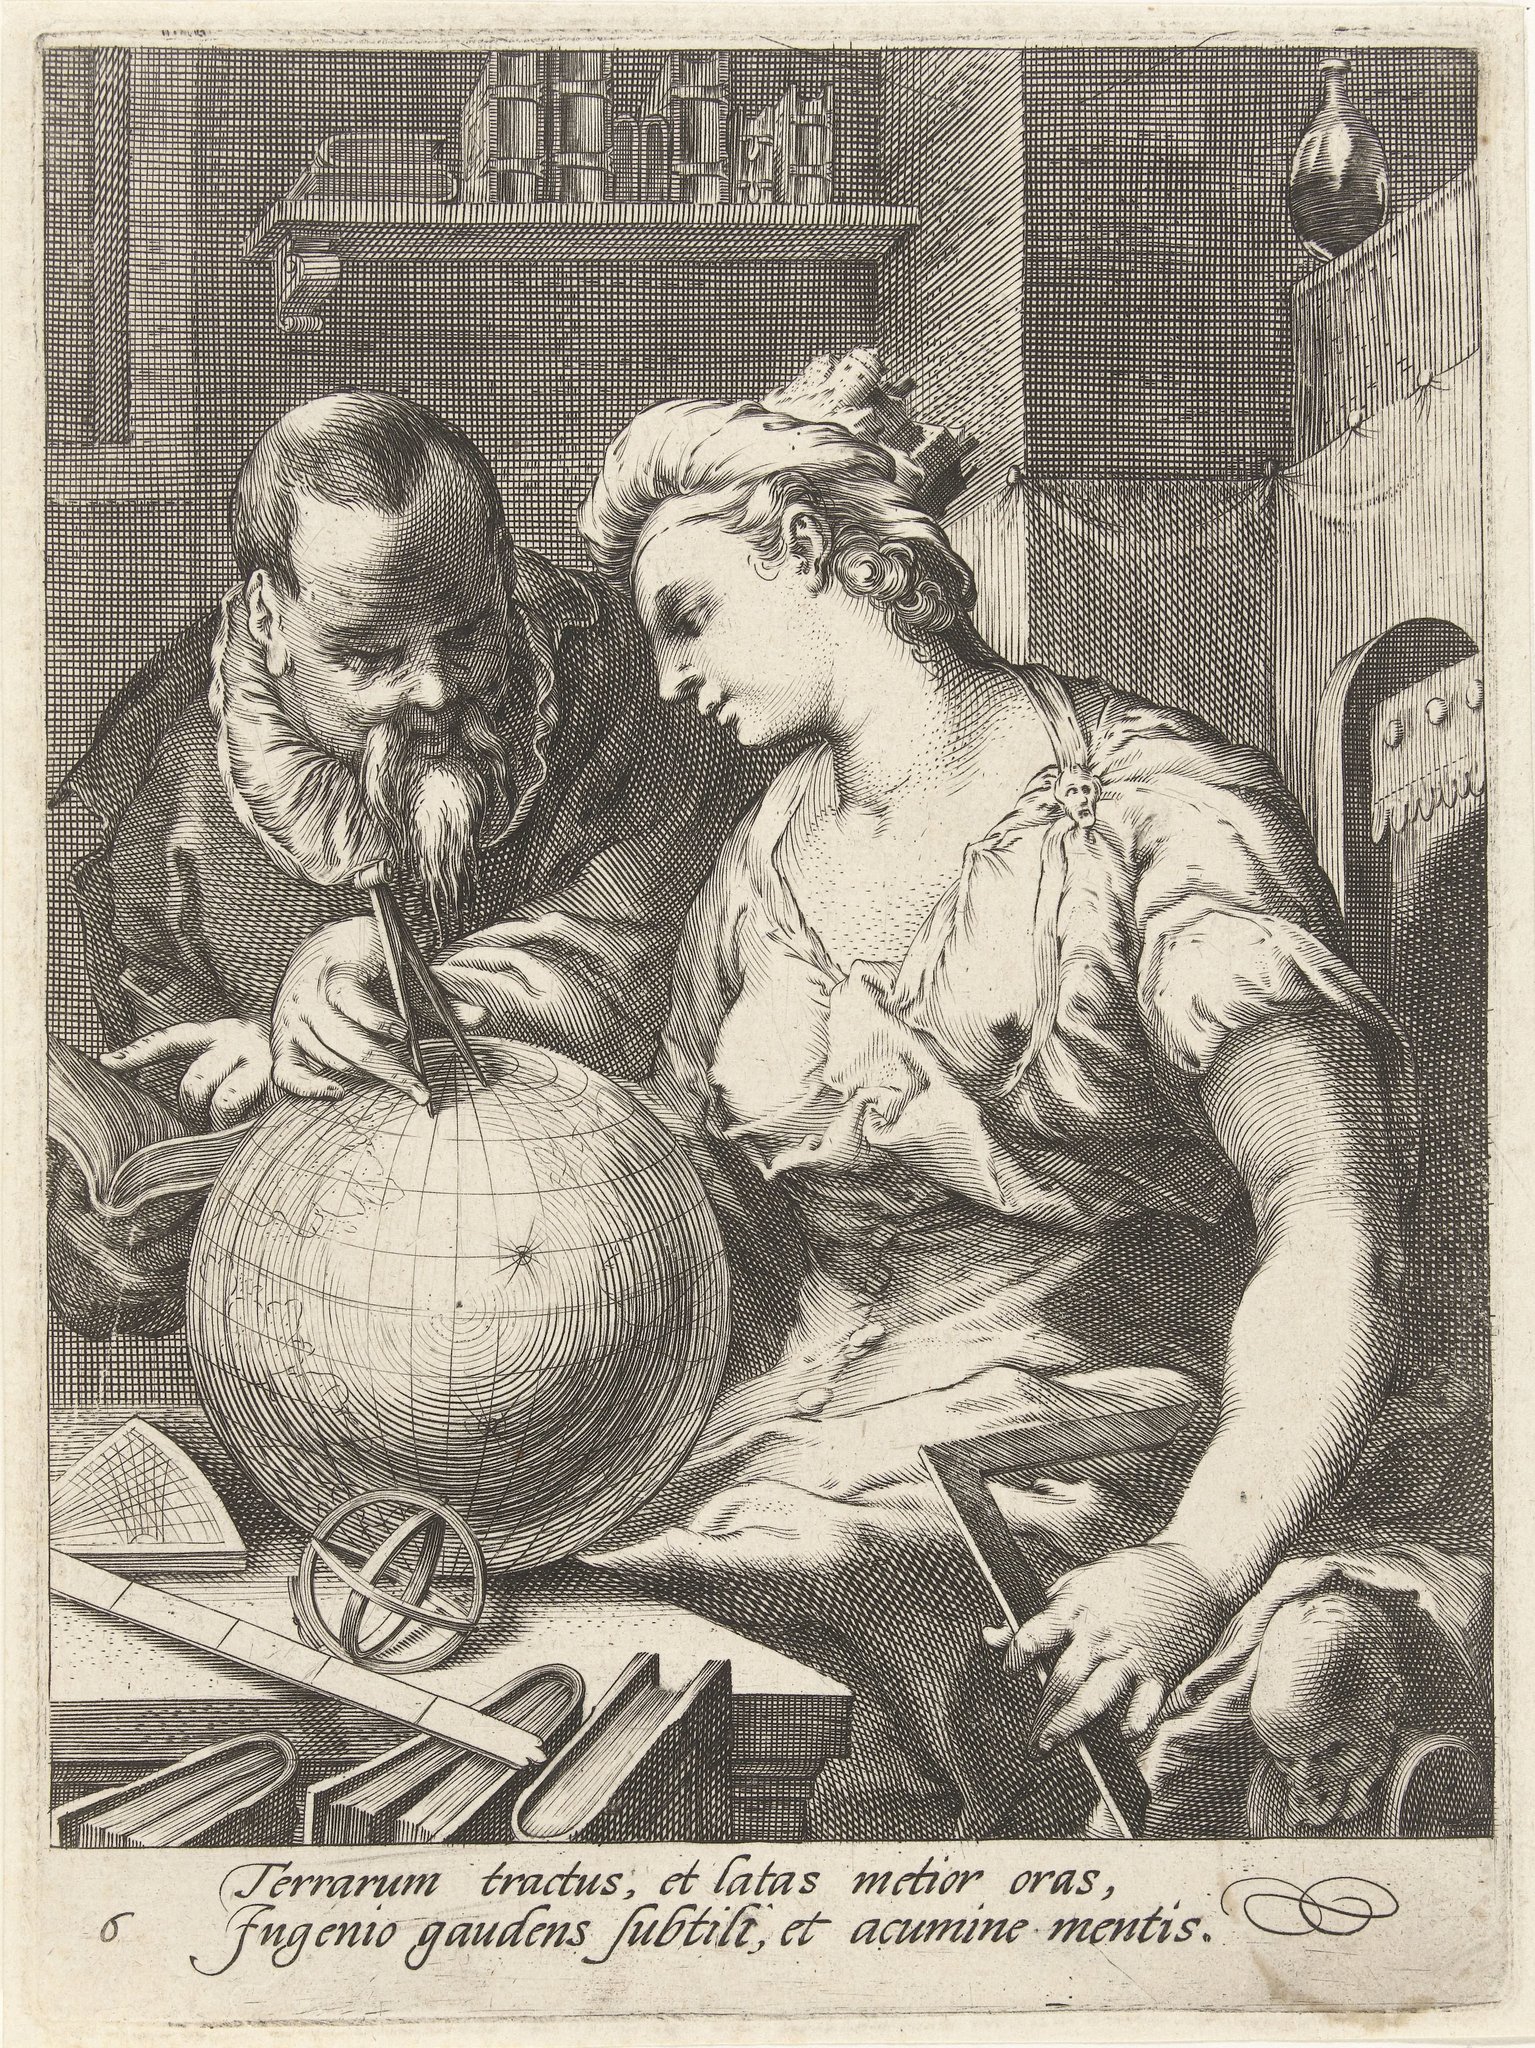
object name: print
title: Meetkunde (Geometria)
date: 1587-1605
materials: paper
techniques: engraving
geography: netherlands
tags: 'geometria' (~ quadrivium); 'geometria' (ripa)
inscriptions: collector's mark: Lugt 240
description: Meetkunde zit aan tafel en meet de afstand tussen twee plaatsen op een globe. Een geleerde leest haar iets voor uit een boek. In de kamer liggen boeken en linialen verstrooid. Met een onderschrift in het Latijn door C. Schonaeus.